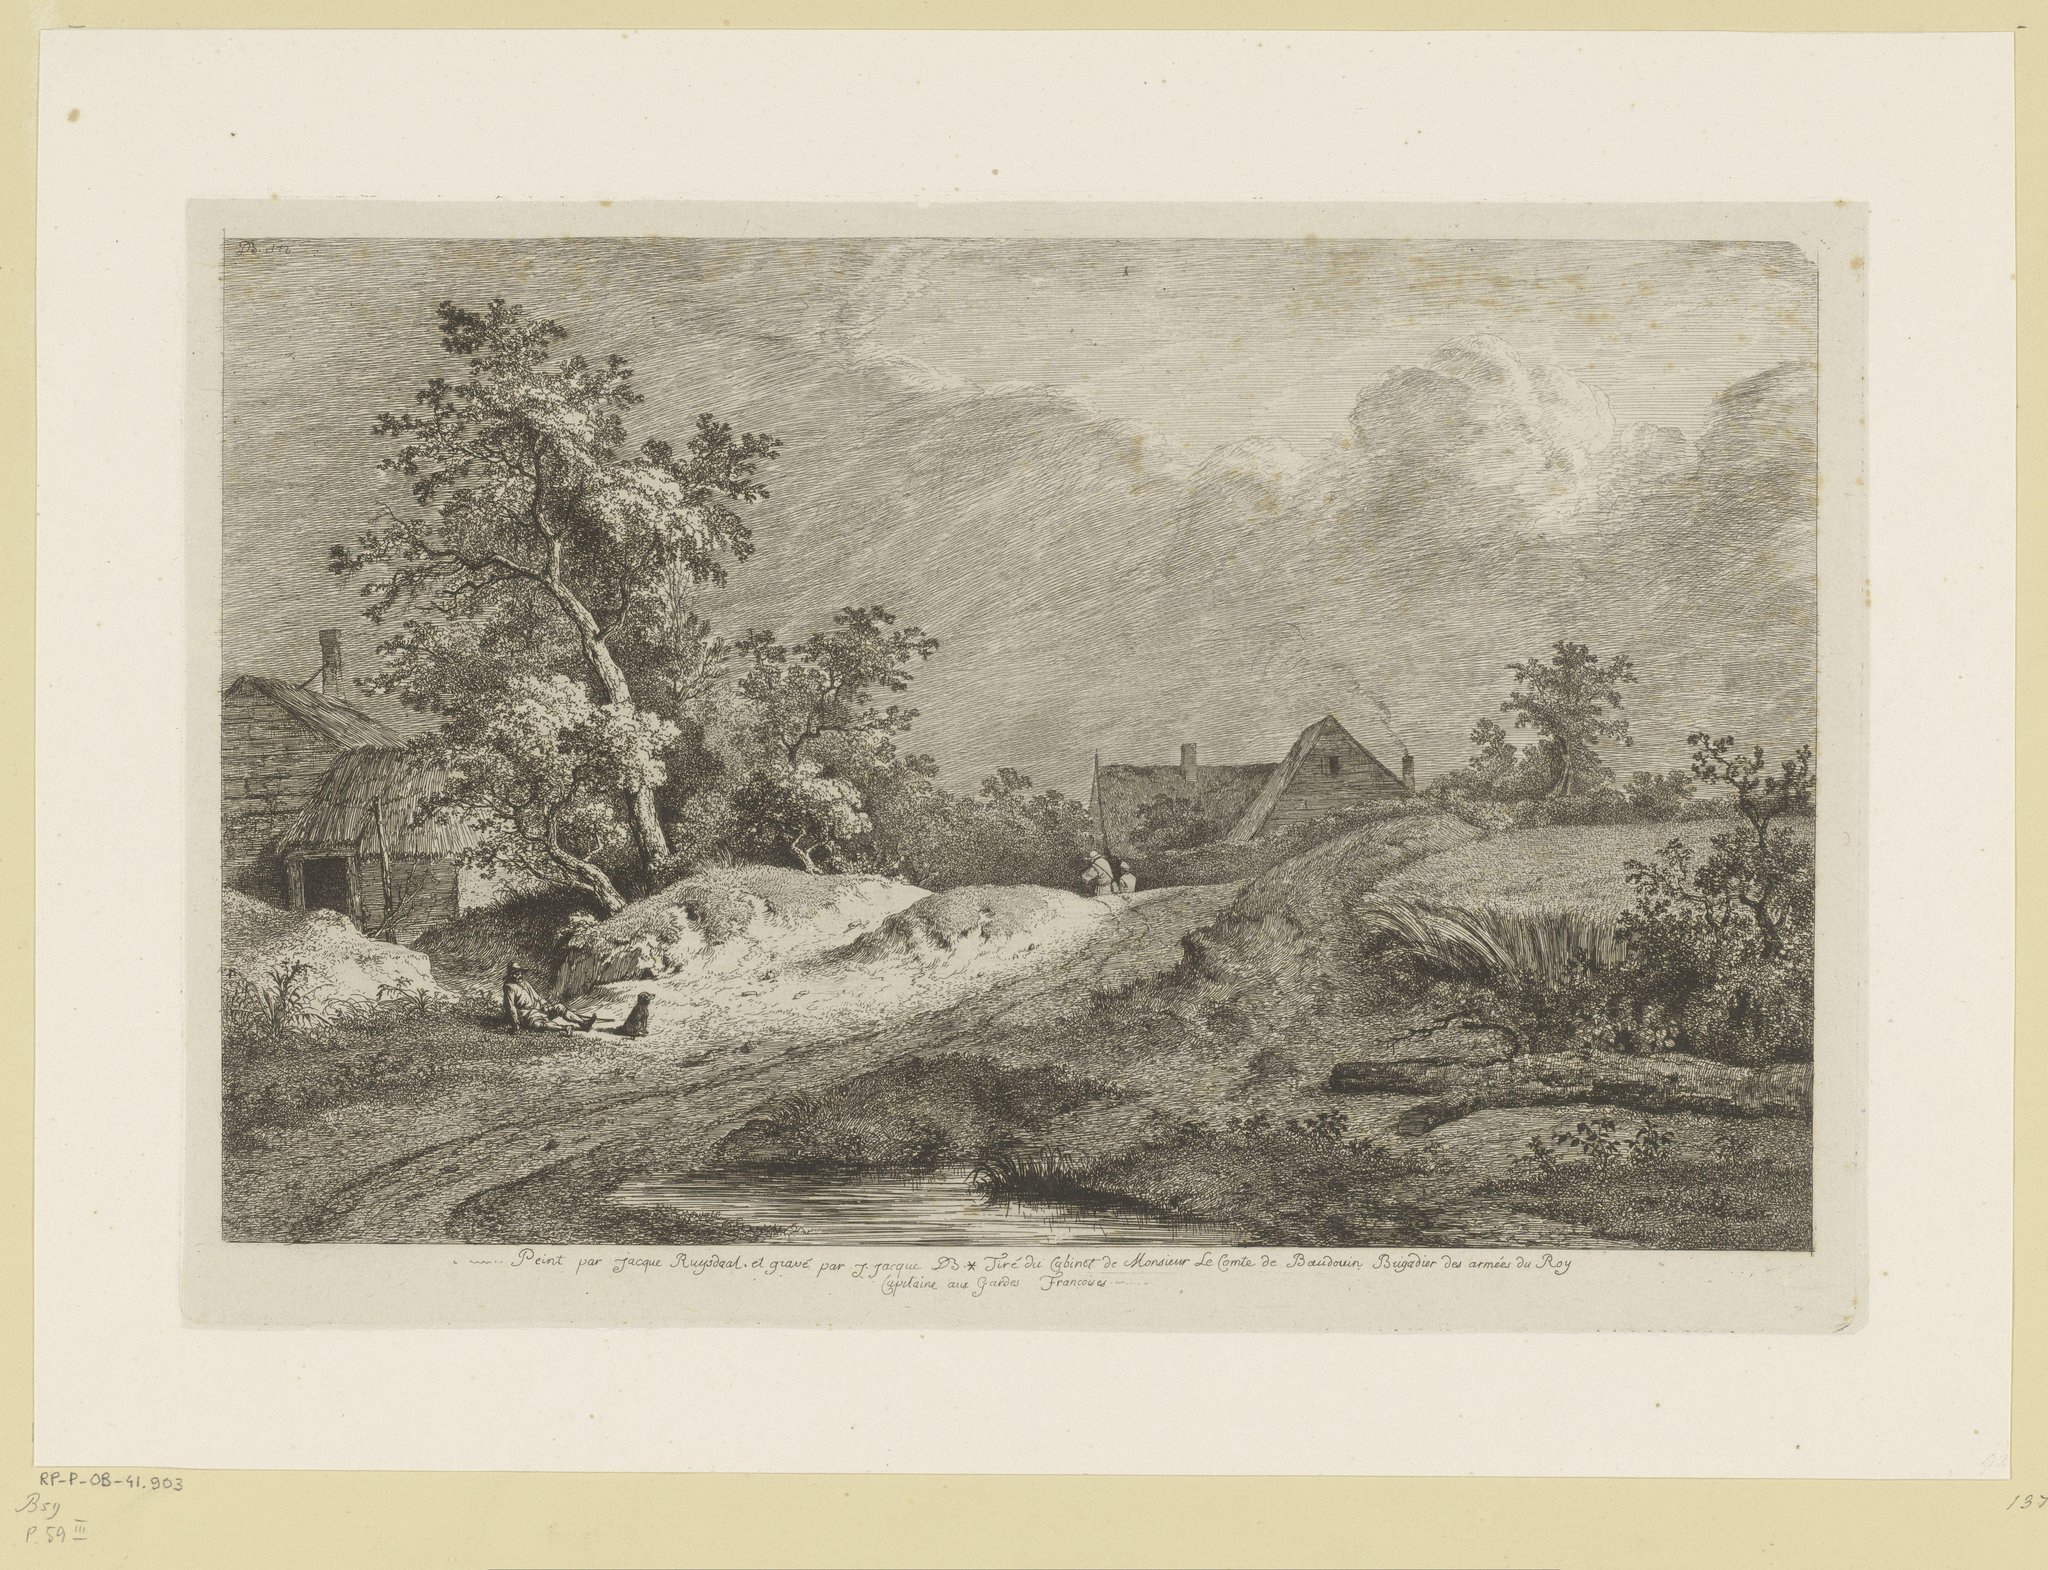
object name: print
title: Landschap met twee huizen bij een korenveld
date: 1772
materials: paper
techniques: drypoint, etching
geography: france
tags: field filled with a crop, cereal, grain, corn (grass with grains, grown for food, e.g.: wheat, rice, rye, oats, maize, buckwheat, millet), landscapes (+ landscape with figures, staffage)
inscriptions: collector's mark: Lugt 12